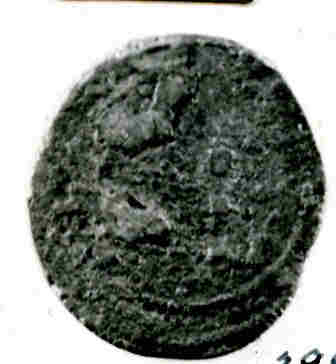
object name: coin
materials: copper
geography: iran